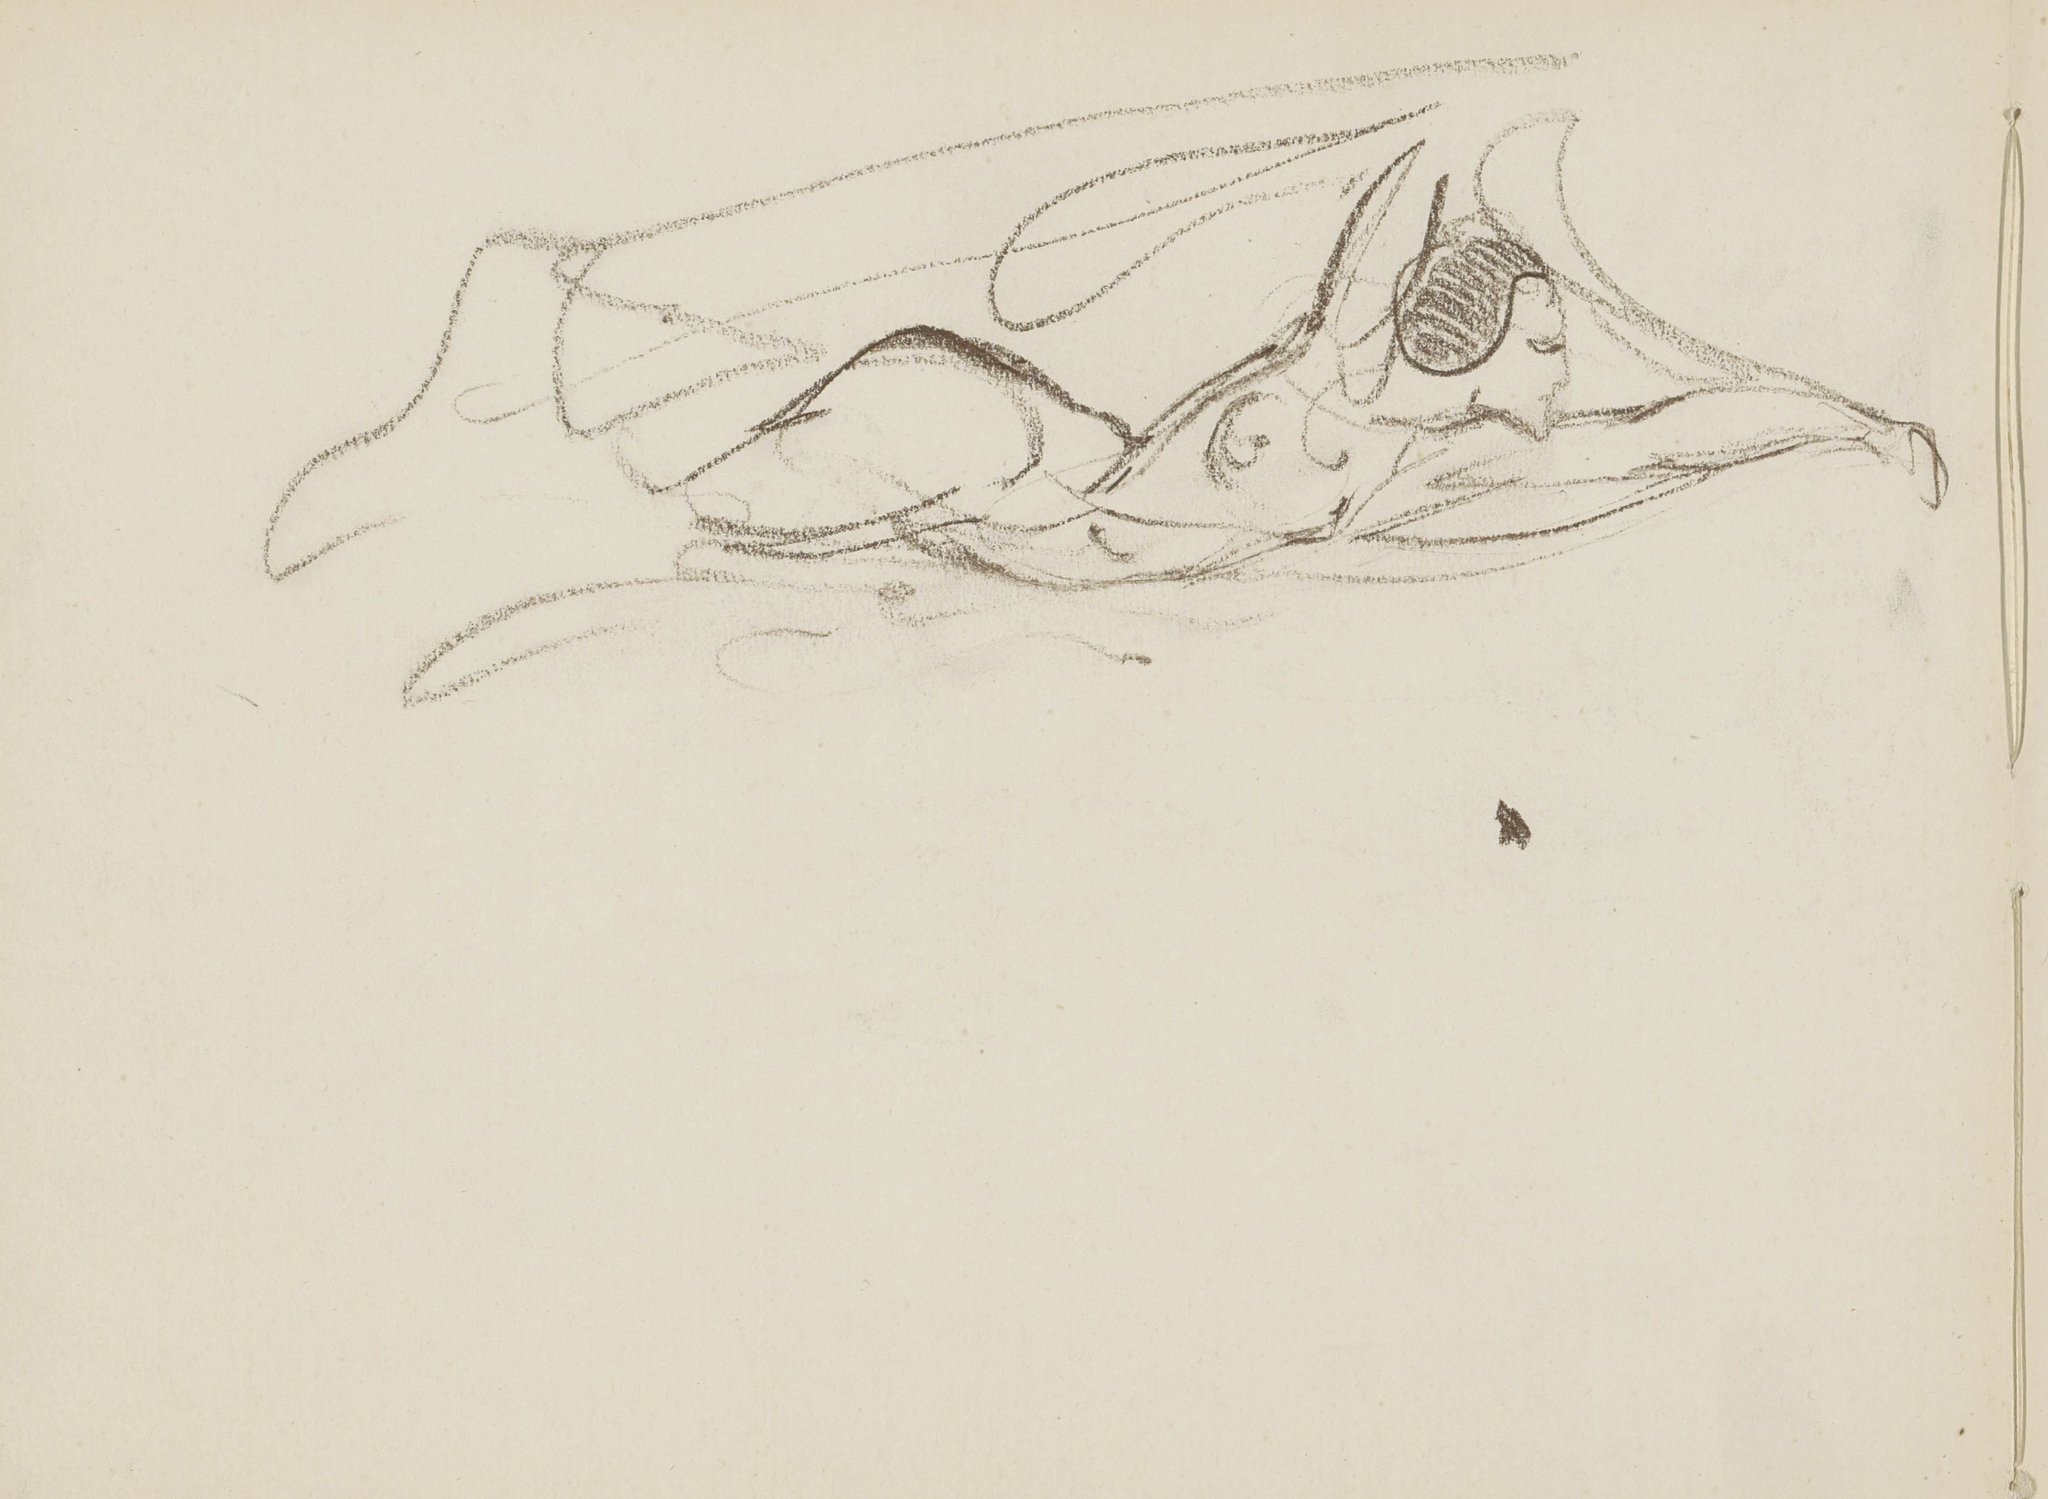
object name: sketchbook leaf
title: Fantasiefiguur met uitgestrekte armen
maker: monogrammist ds (tekenaar)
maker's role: draughtsman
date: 1850-1950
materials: chalk, paper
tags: arm stretched forward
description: Blad 2 verso uit een schetsboek met 17 bladen.